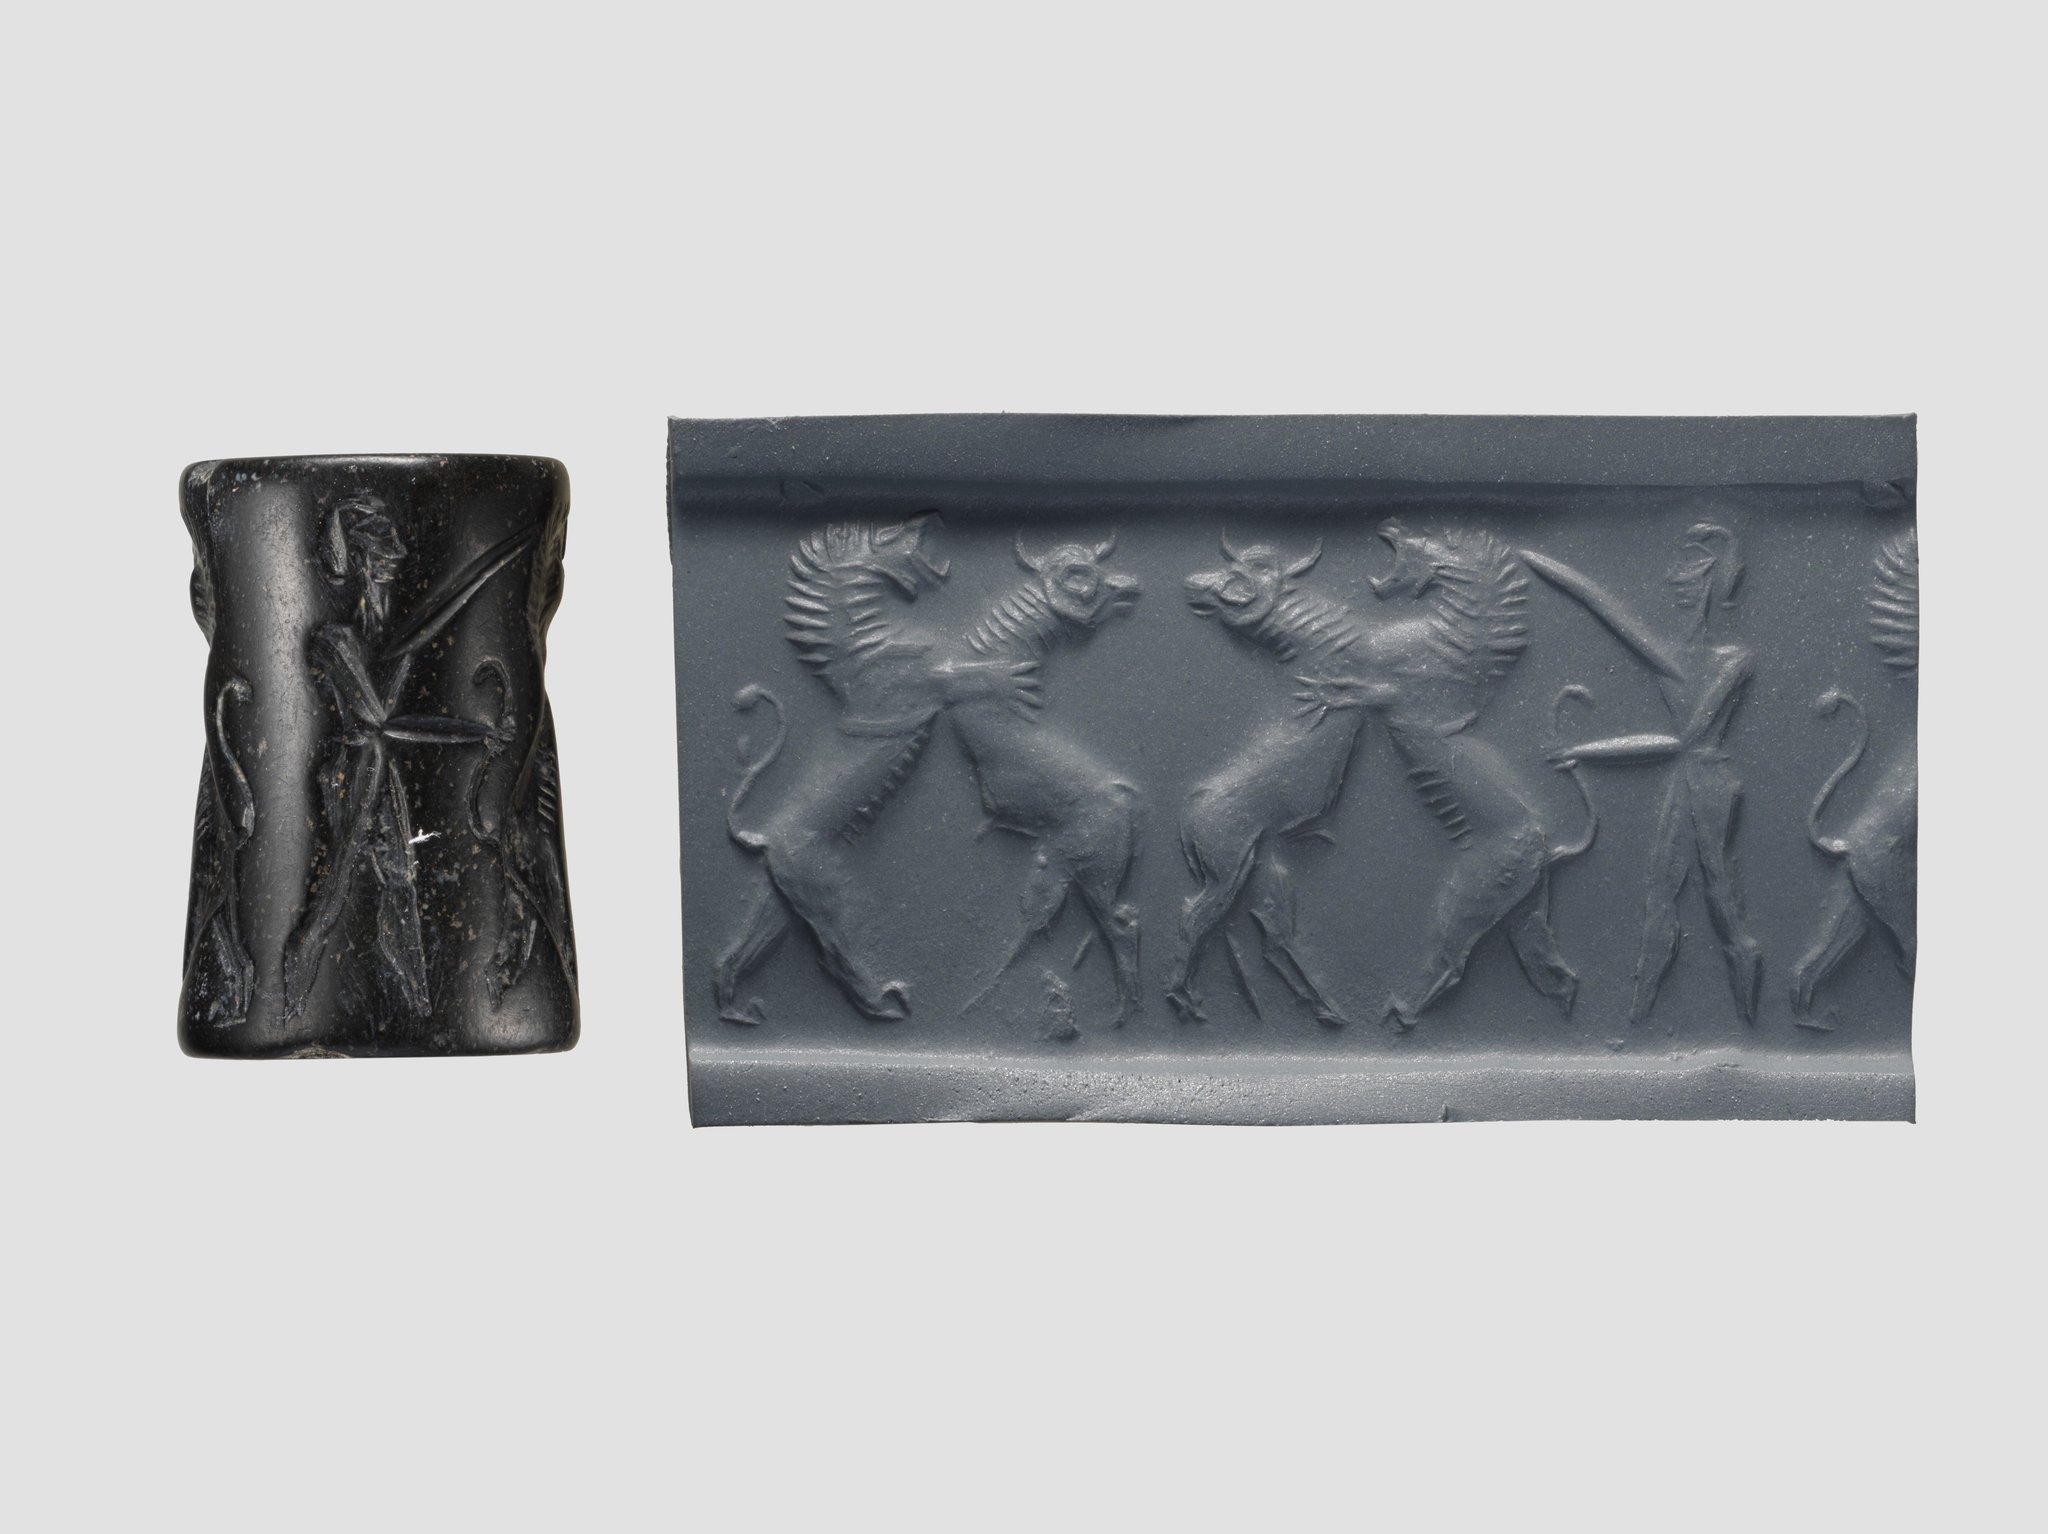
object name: cylinder seal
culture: akkadian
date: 2350-2150 BCE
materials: stone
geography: mesopotamia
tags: animals